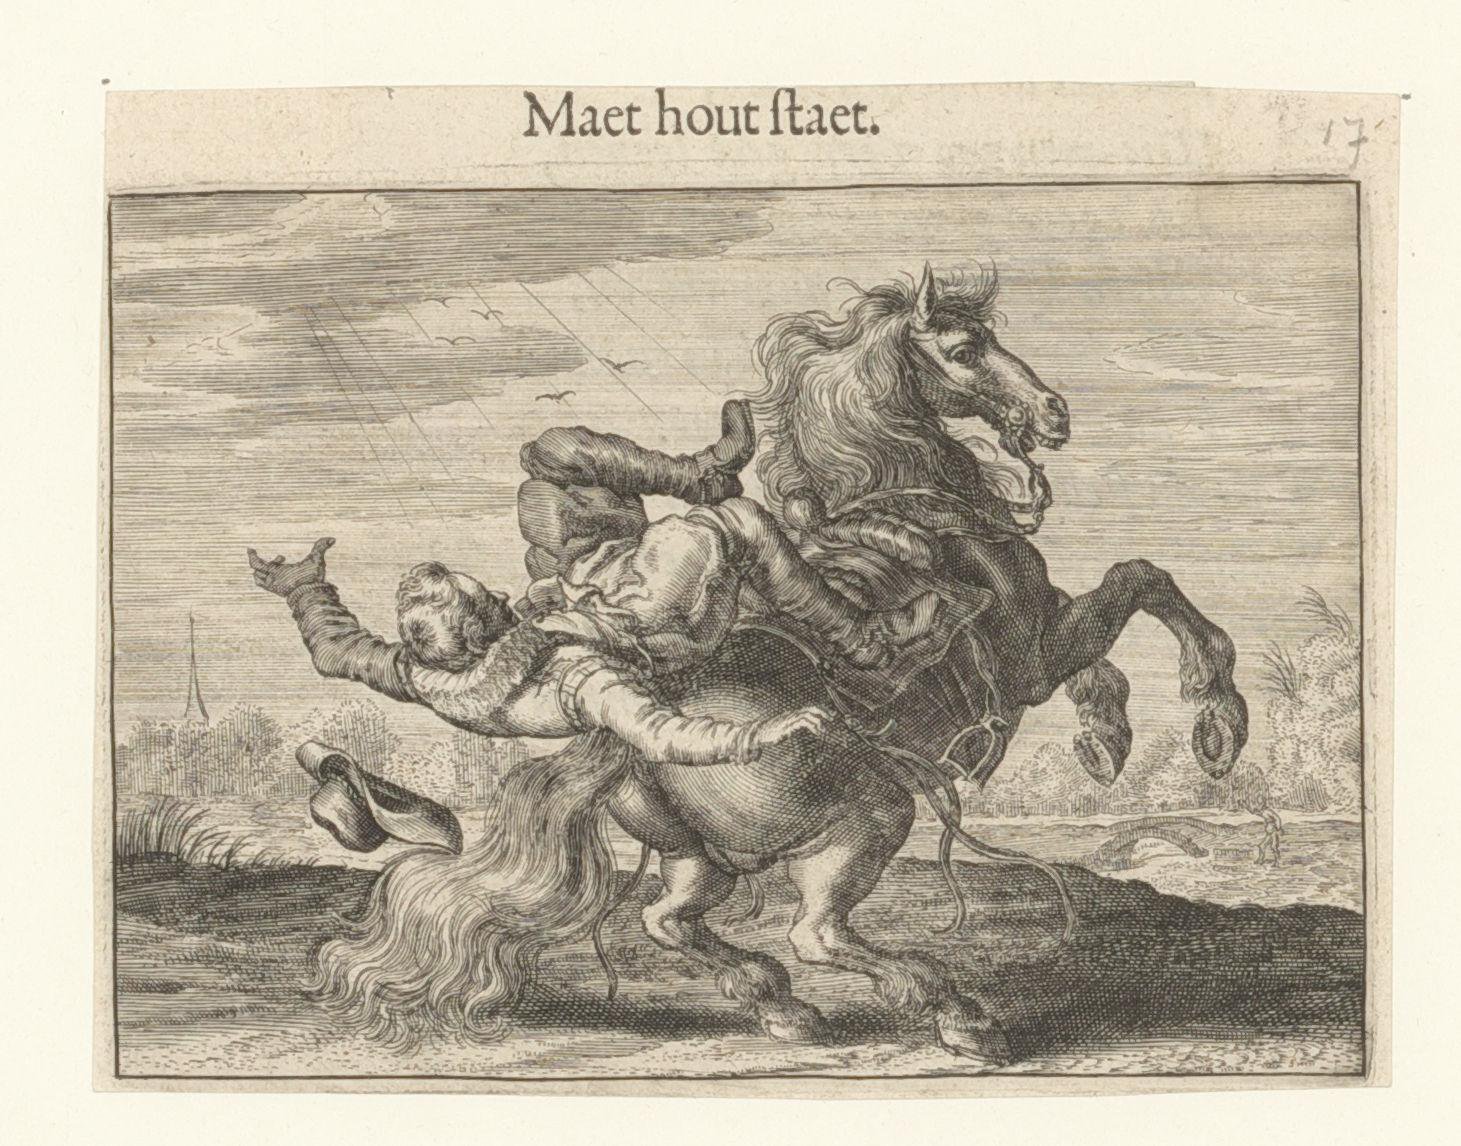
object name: book illustration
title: Steigerend paard gooit zijn berijder van zijn rug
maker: Anonymous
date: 1624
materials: paper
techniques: engraving, letterpress printing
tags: horse throwing rider, adult man, proverbs, sayings, etc., vicissitudes of life, horse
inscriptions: collector's mark: Lugt 1641, stamp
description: Zeventiende embleem uit: Brune, Johan de. Zinne-werck, Voor-ghesyelt in Beelden, Ghedichten, ende breeder uyt-legginghen (...). Amsterdam: Evertsen Kloppenburch, 1624. Prent ook gebruikt in latere edities (1636 en 1661).